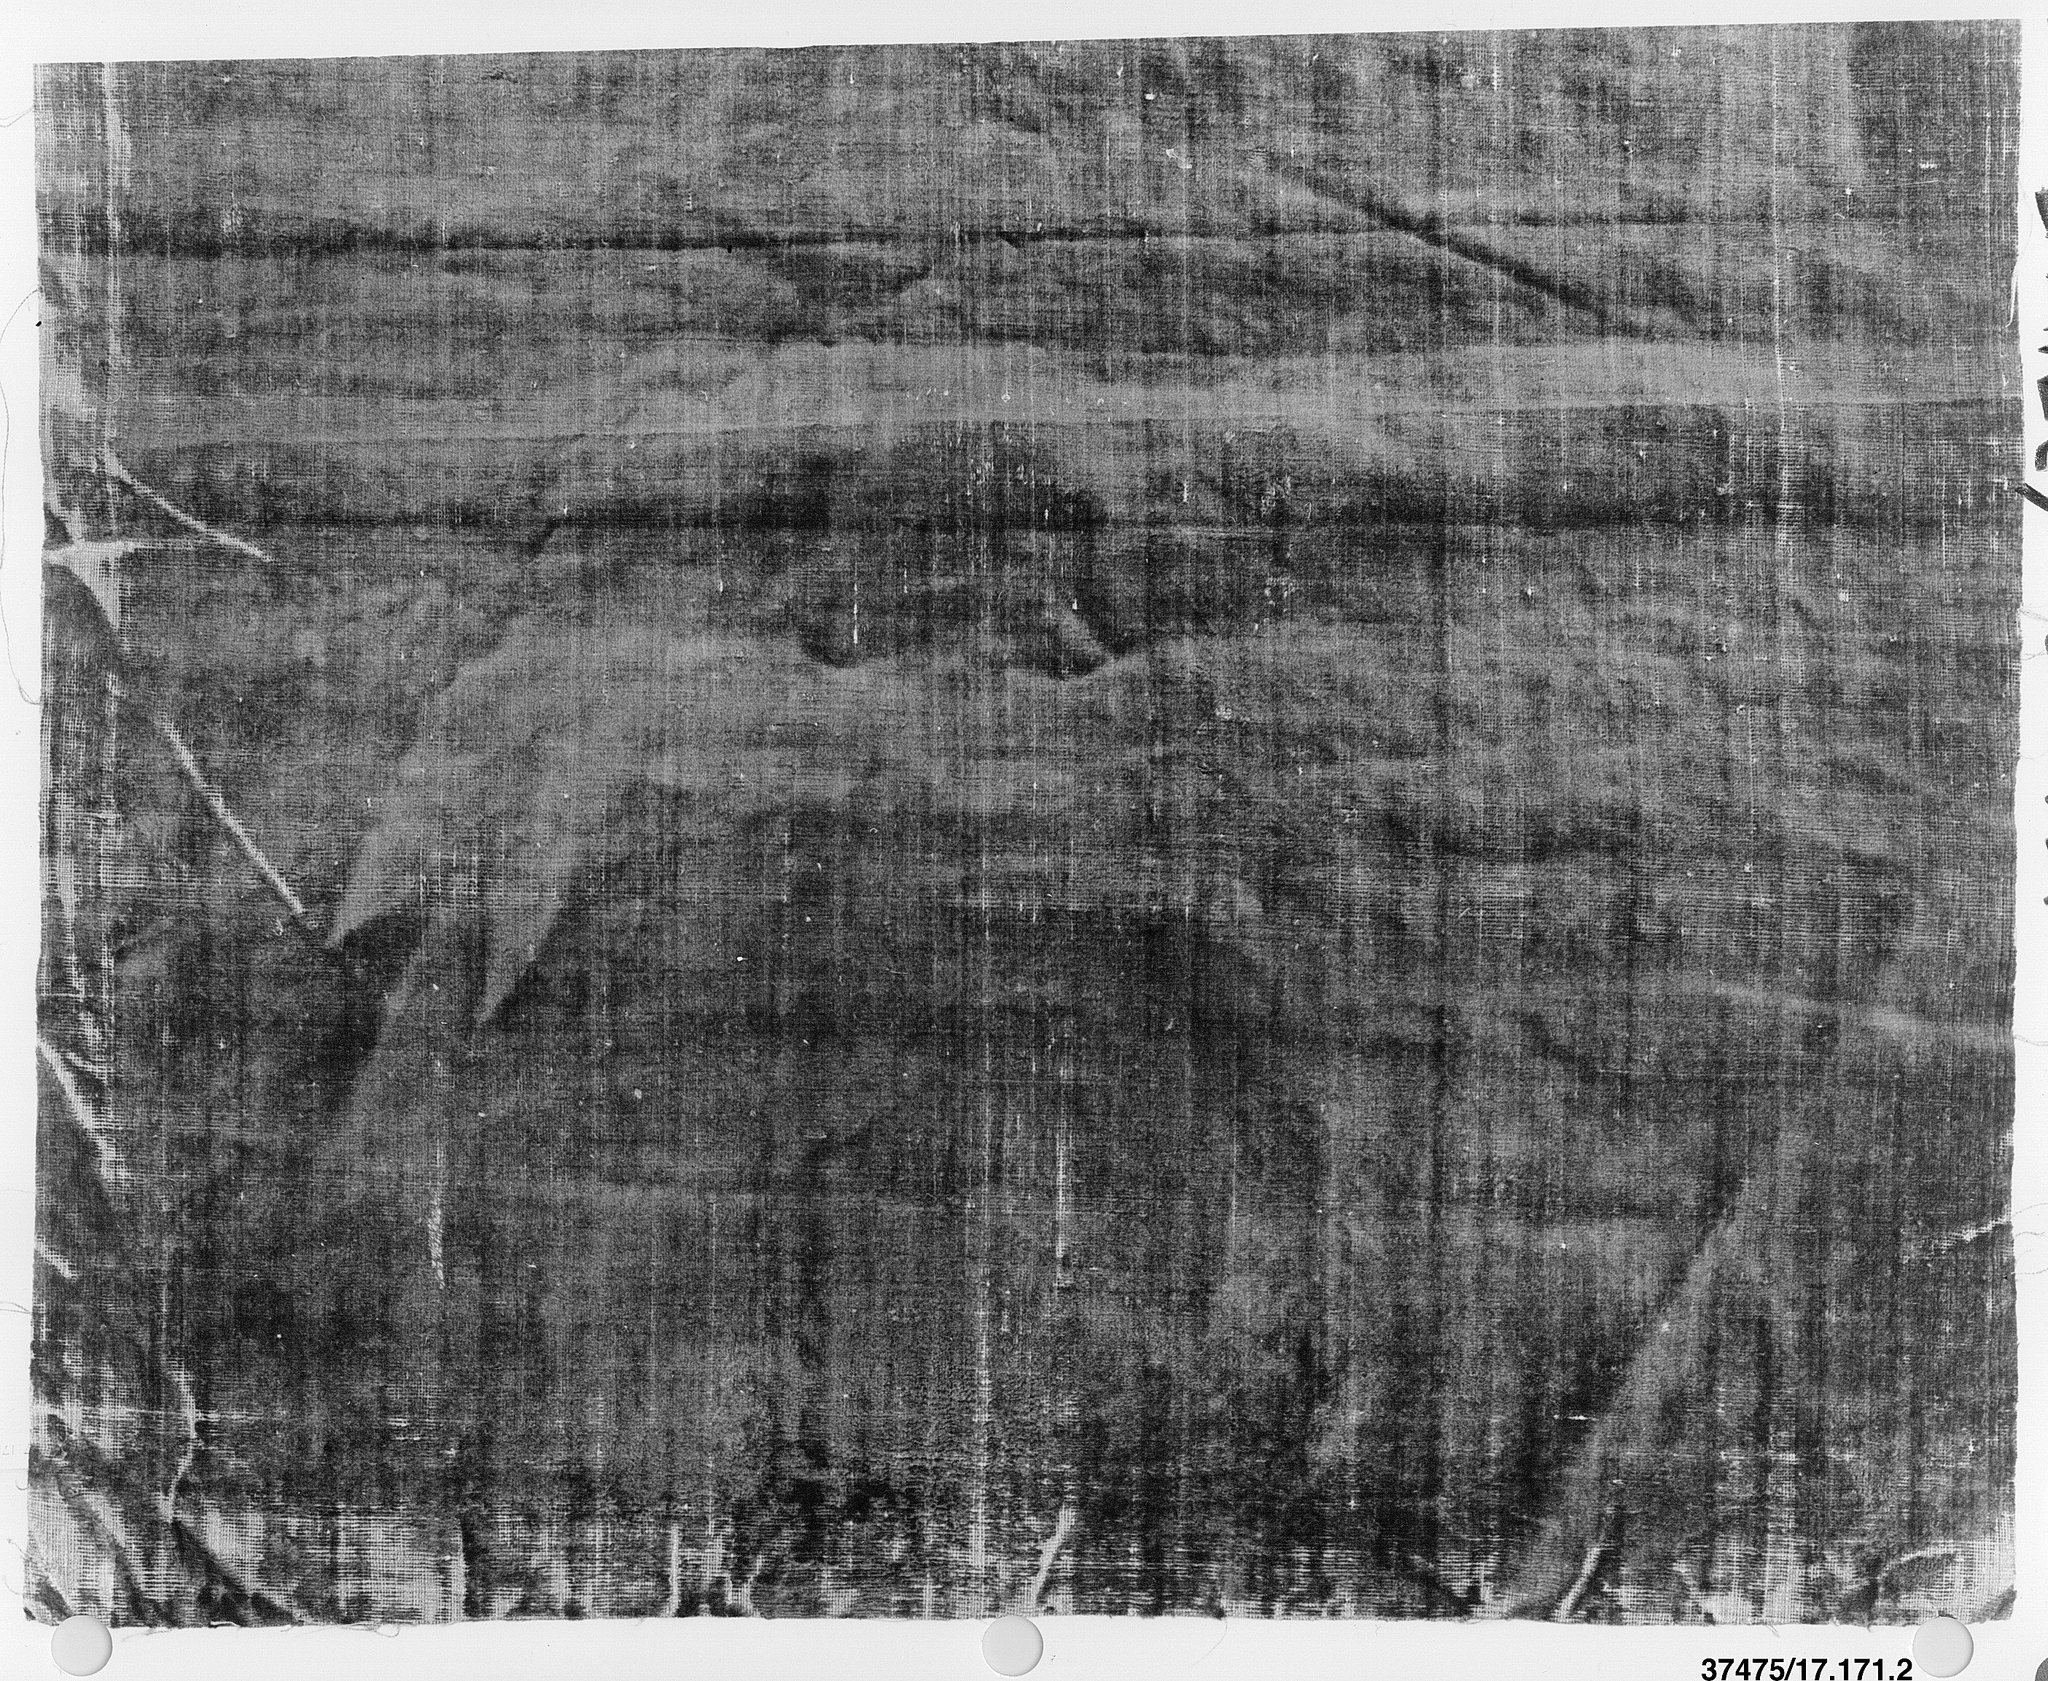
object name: piece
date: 1501-1600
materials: linen, silk